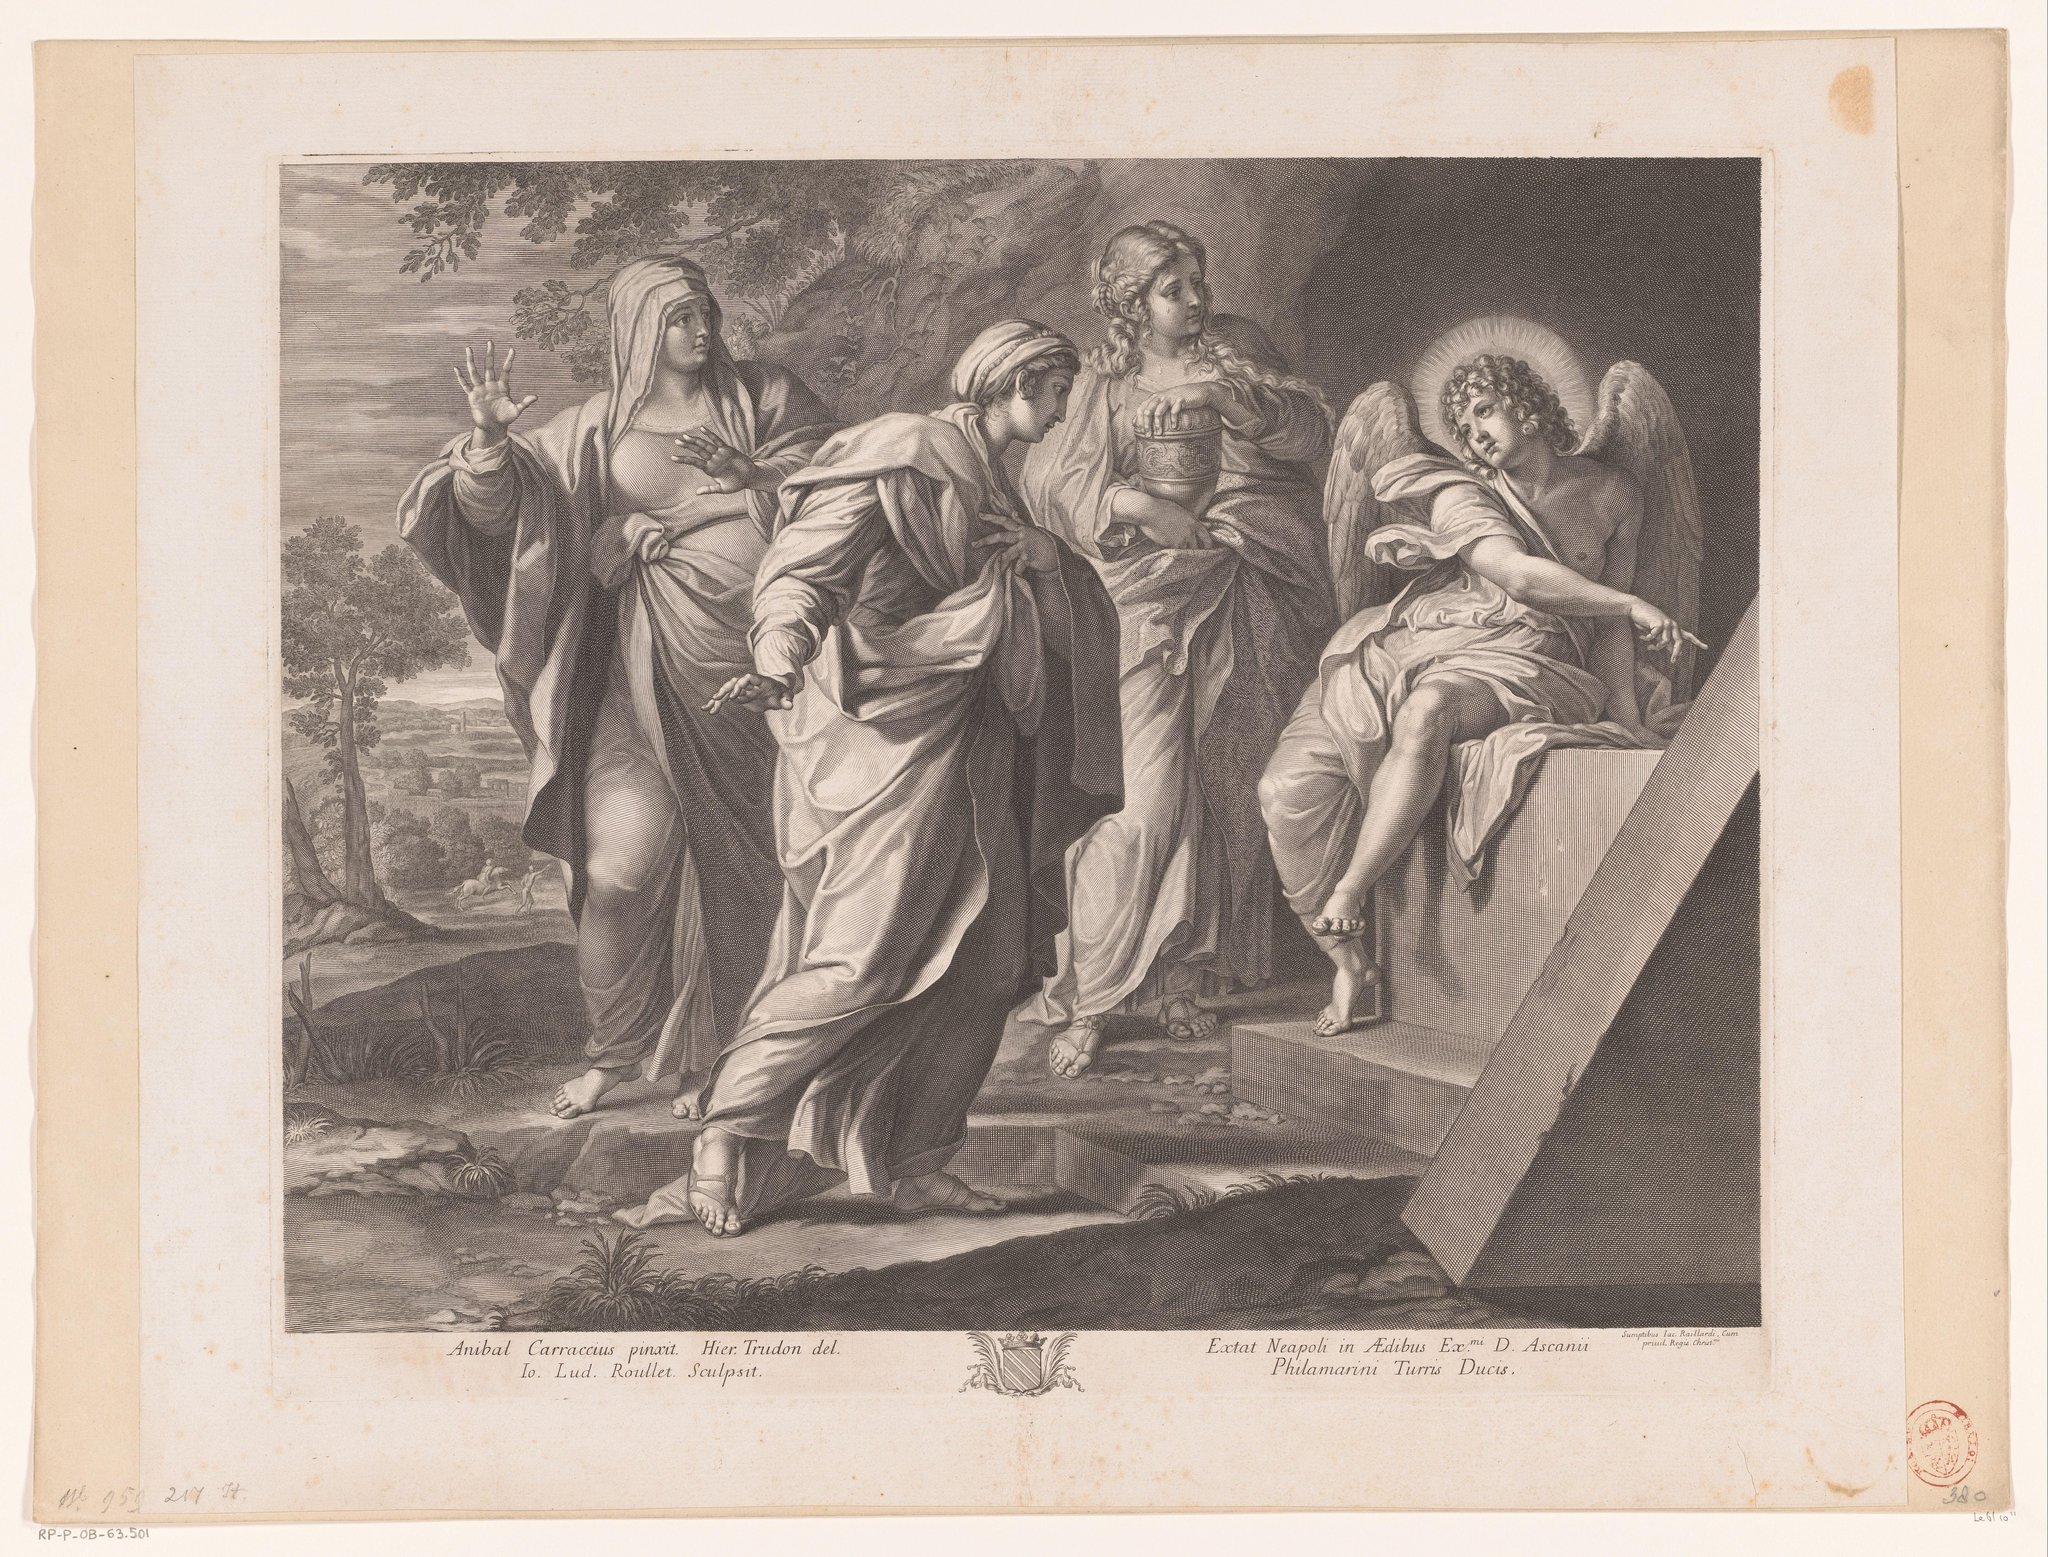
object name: print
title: Engel wijst de drie vrouwen op het lege graf van Christus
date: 1655-1699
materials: paper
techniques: engraving, etching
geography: france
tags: angel(s) addressing the holy women ~ resurrection of christ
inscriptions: collector's mark: Lugt 240